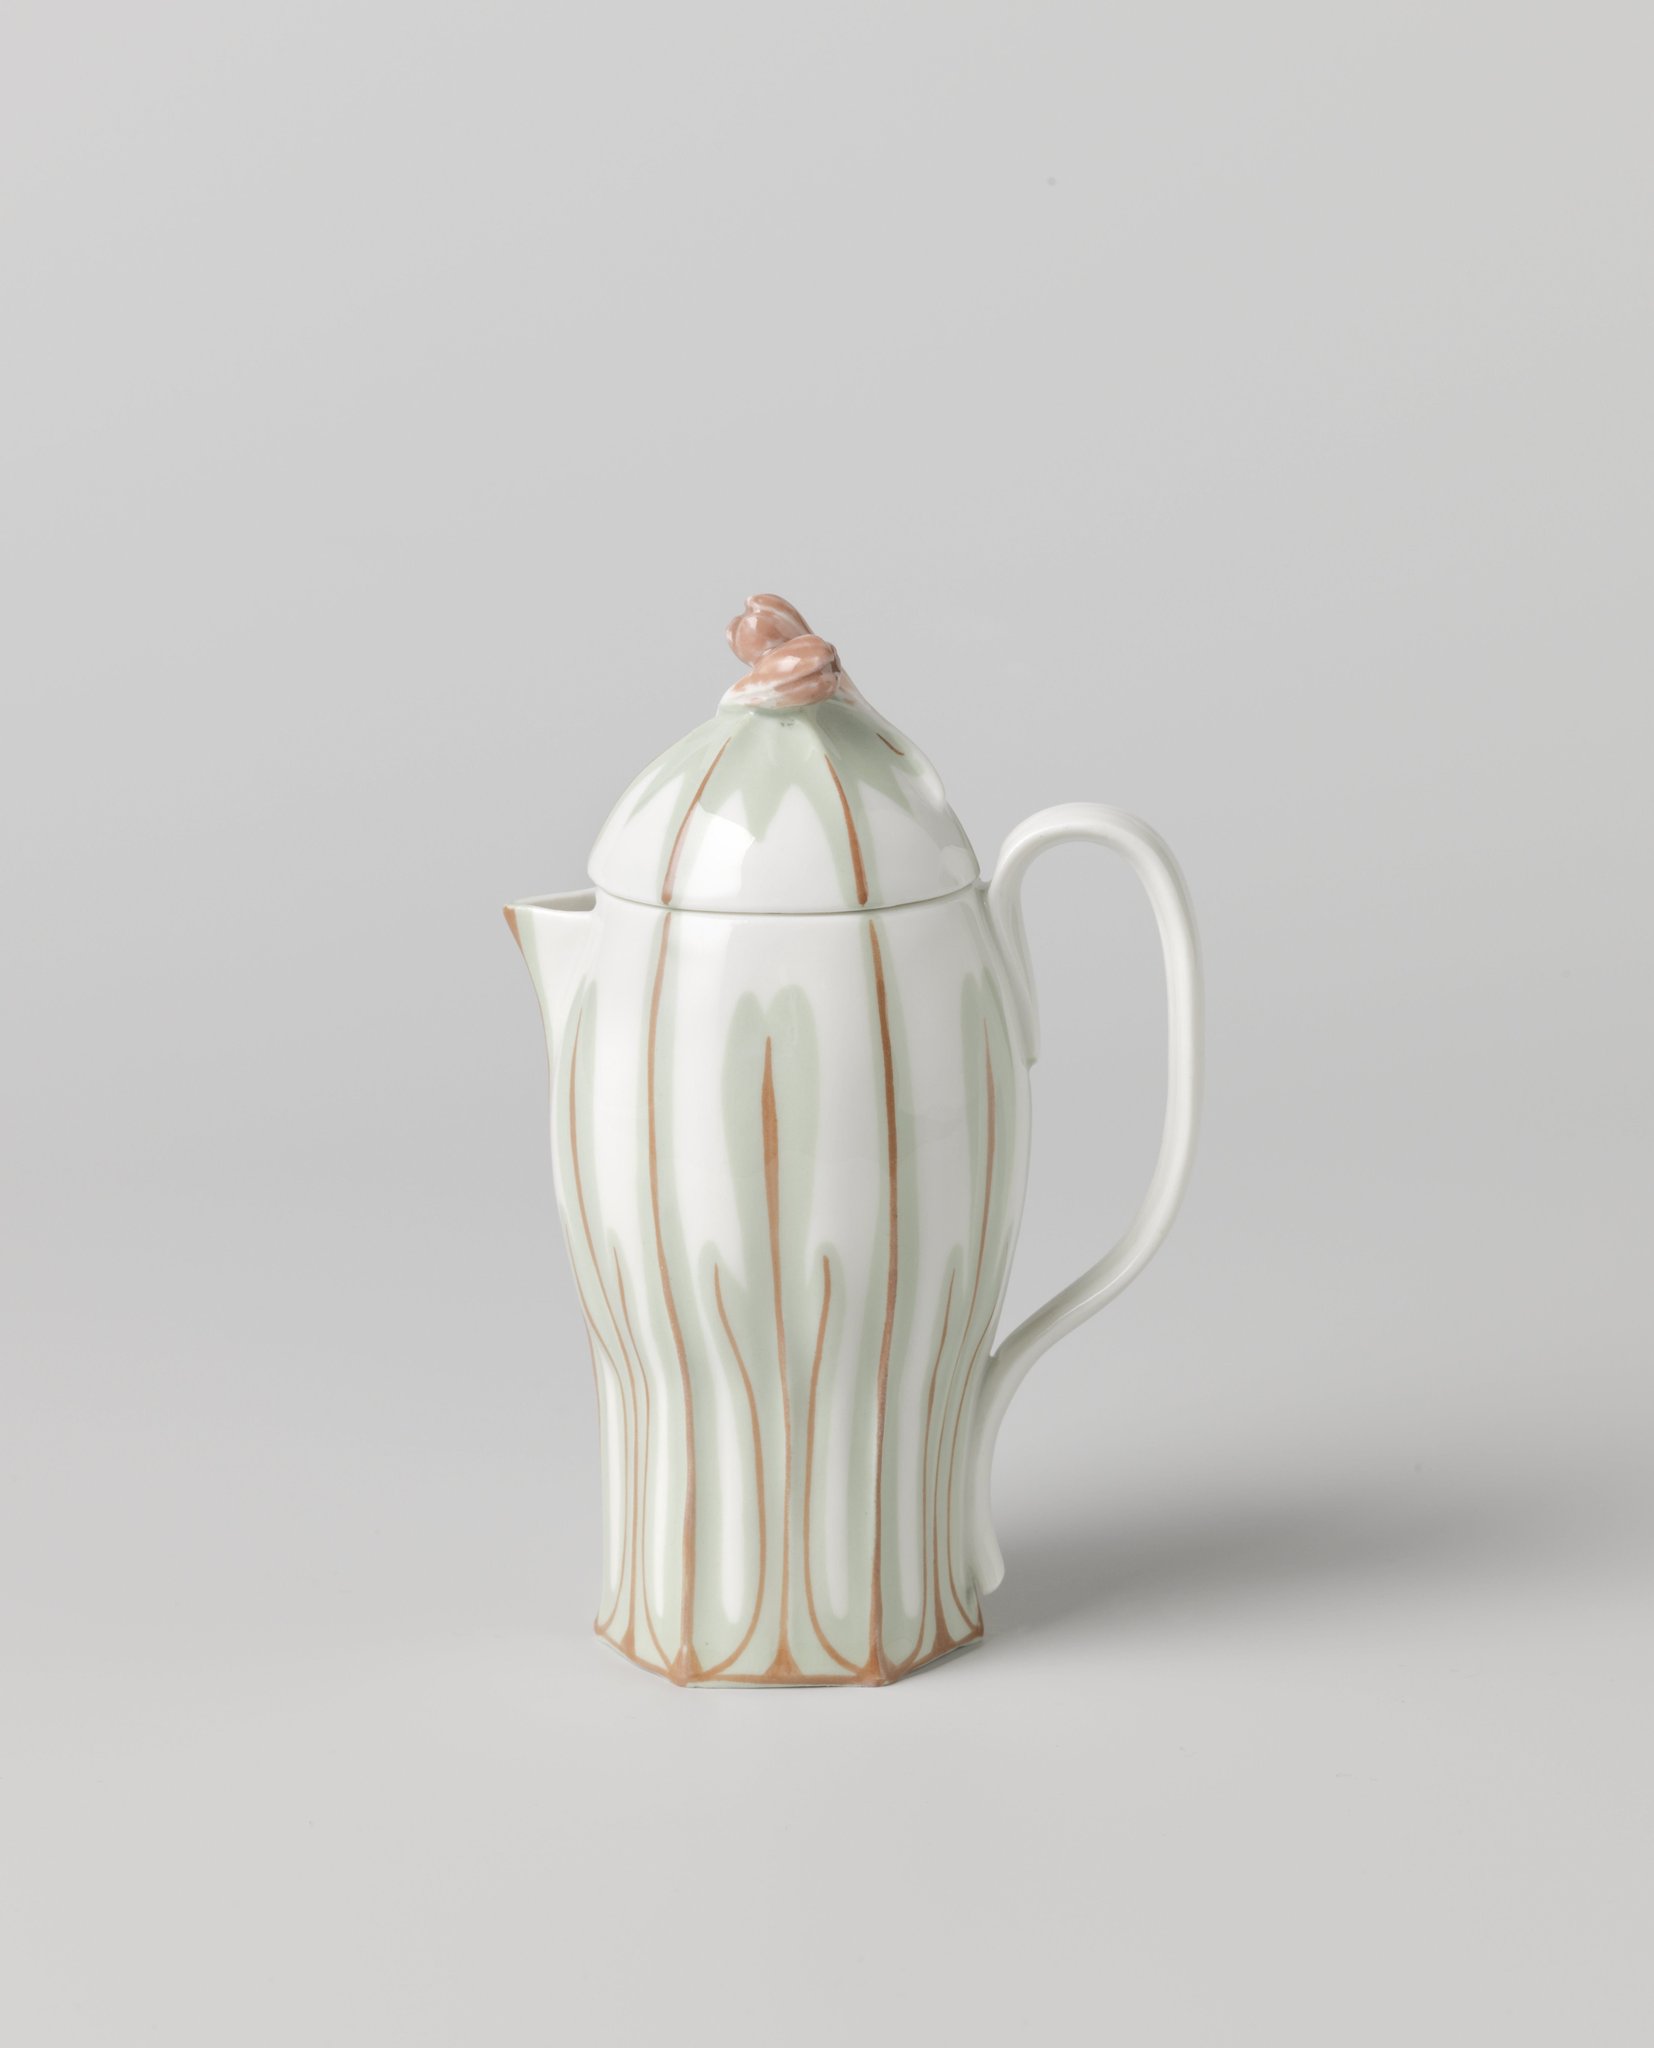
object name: lid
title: Deksel van melkkan beschilderd met het Krokus-decor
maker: konrad hentschel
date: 1896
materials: porcelain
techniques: painted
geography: meissen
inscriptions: factory mark, mark: ‘98’, mark: ‘71’, model number: ‘Q109b’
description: Deksel van melkkan van beschilderd porselein.